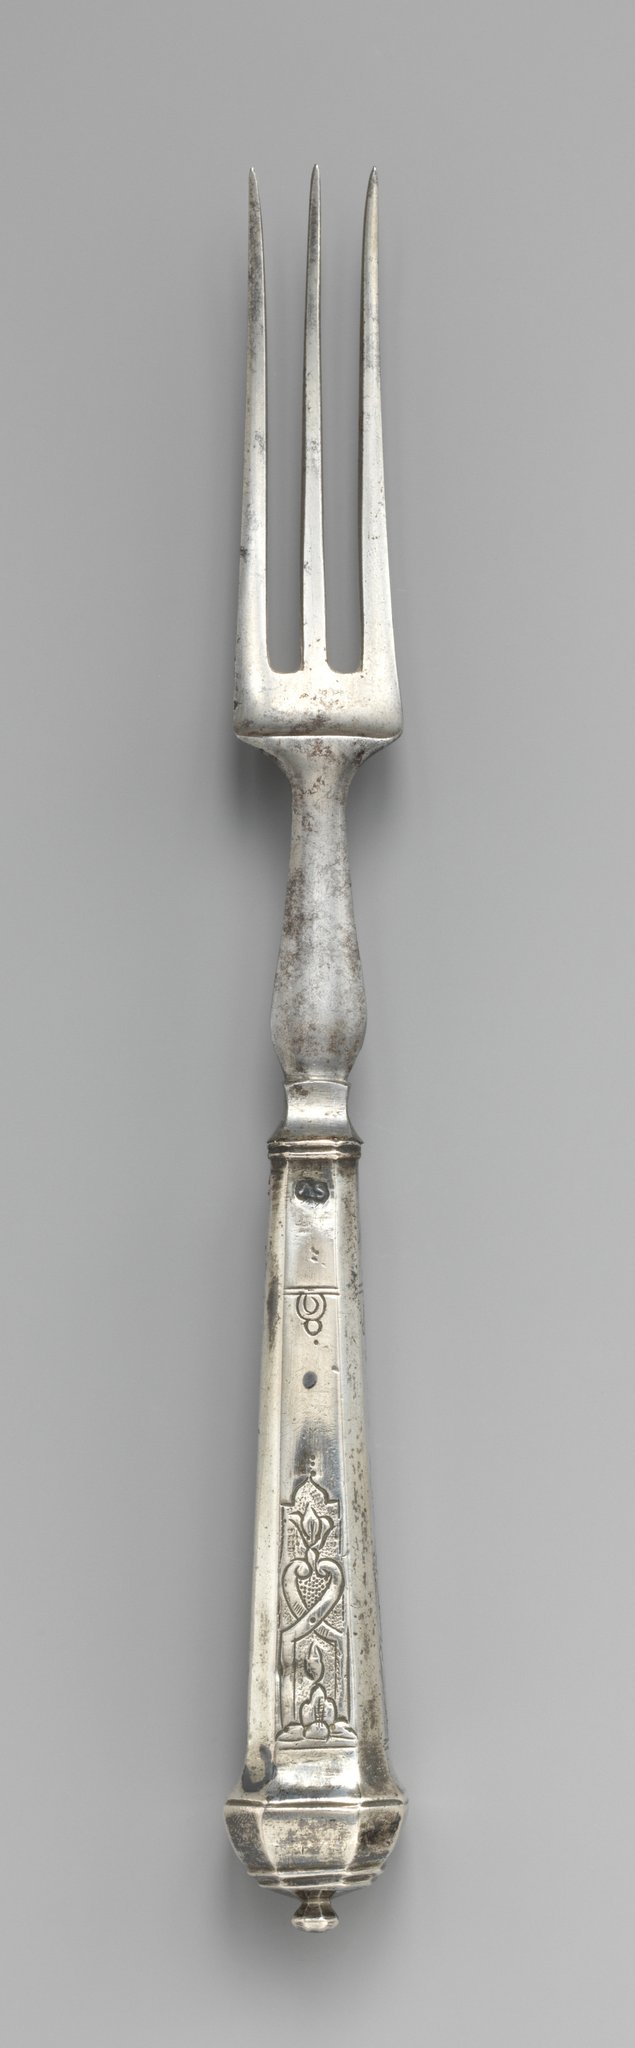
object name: table fork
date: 1801-1833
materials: silver, steel